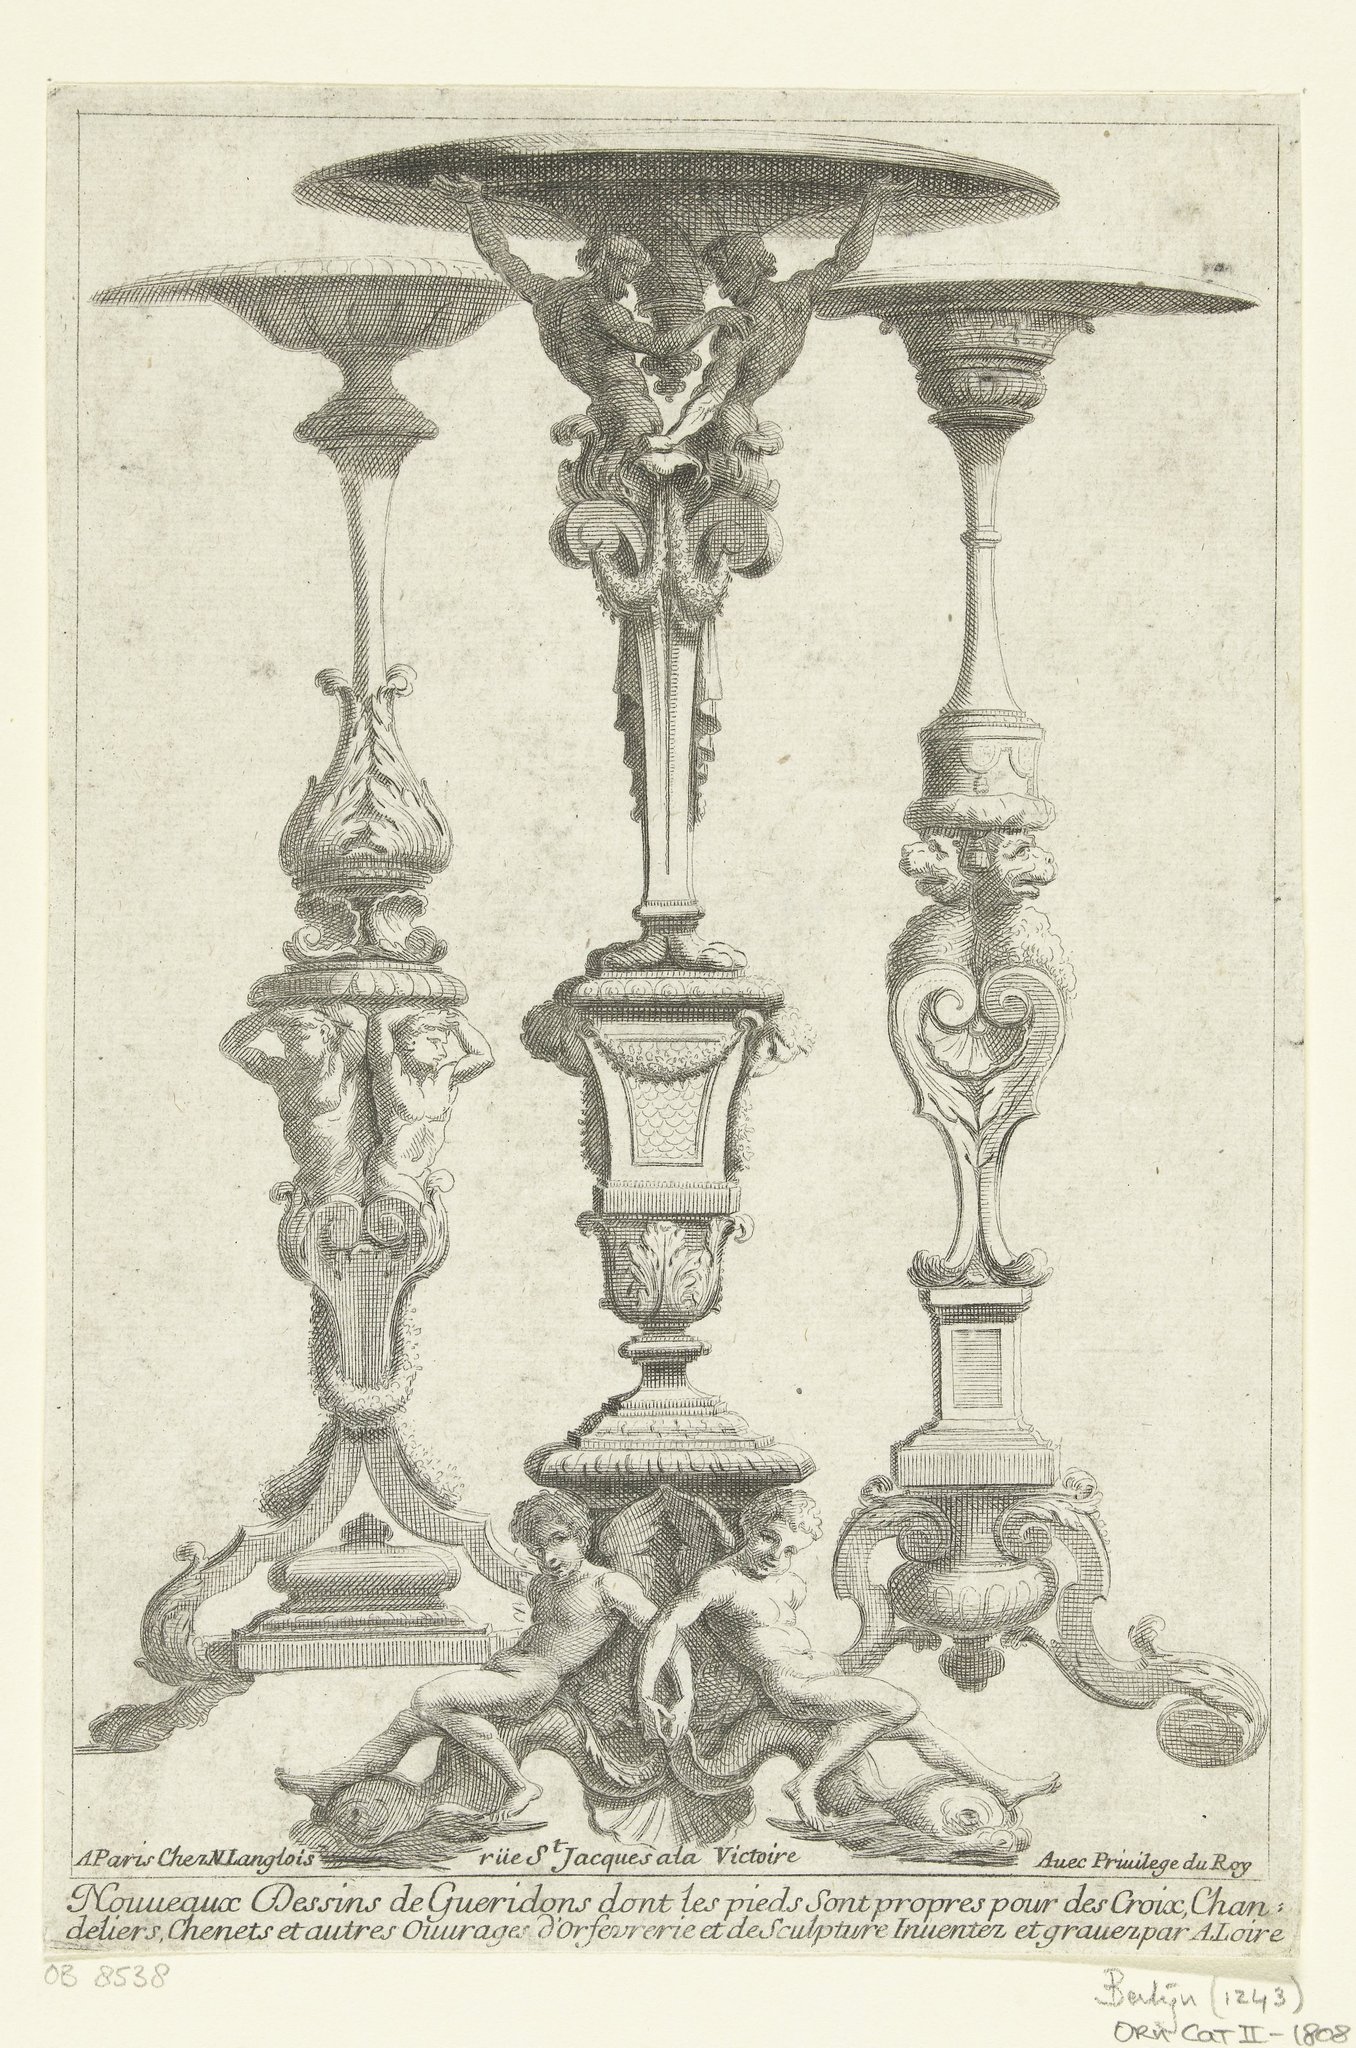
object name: ornament print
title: Nouveaux dessins de guéridons dont les pieds son propres pour des croix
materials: paper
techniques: etching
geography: paris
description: Drie kaarsendragers, de middelste met een voet opgebouwd uit drie gevleugelde jongens die op staarten van dolfijnen zitten. Uit serie van 6 bladen, eerste editie, tweede afdruk.